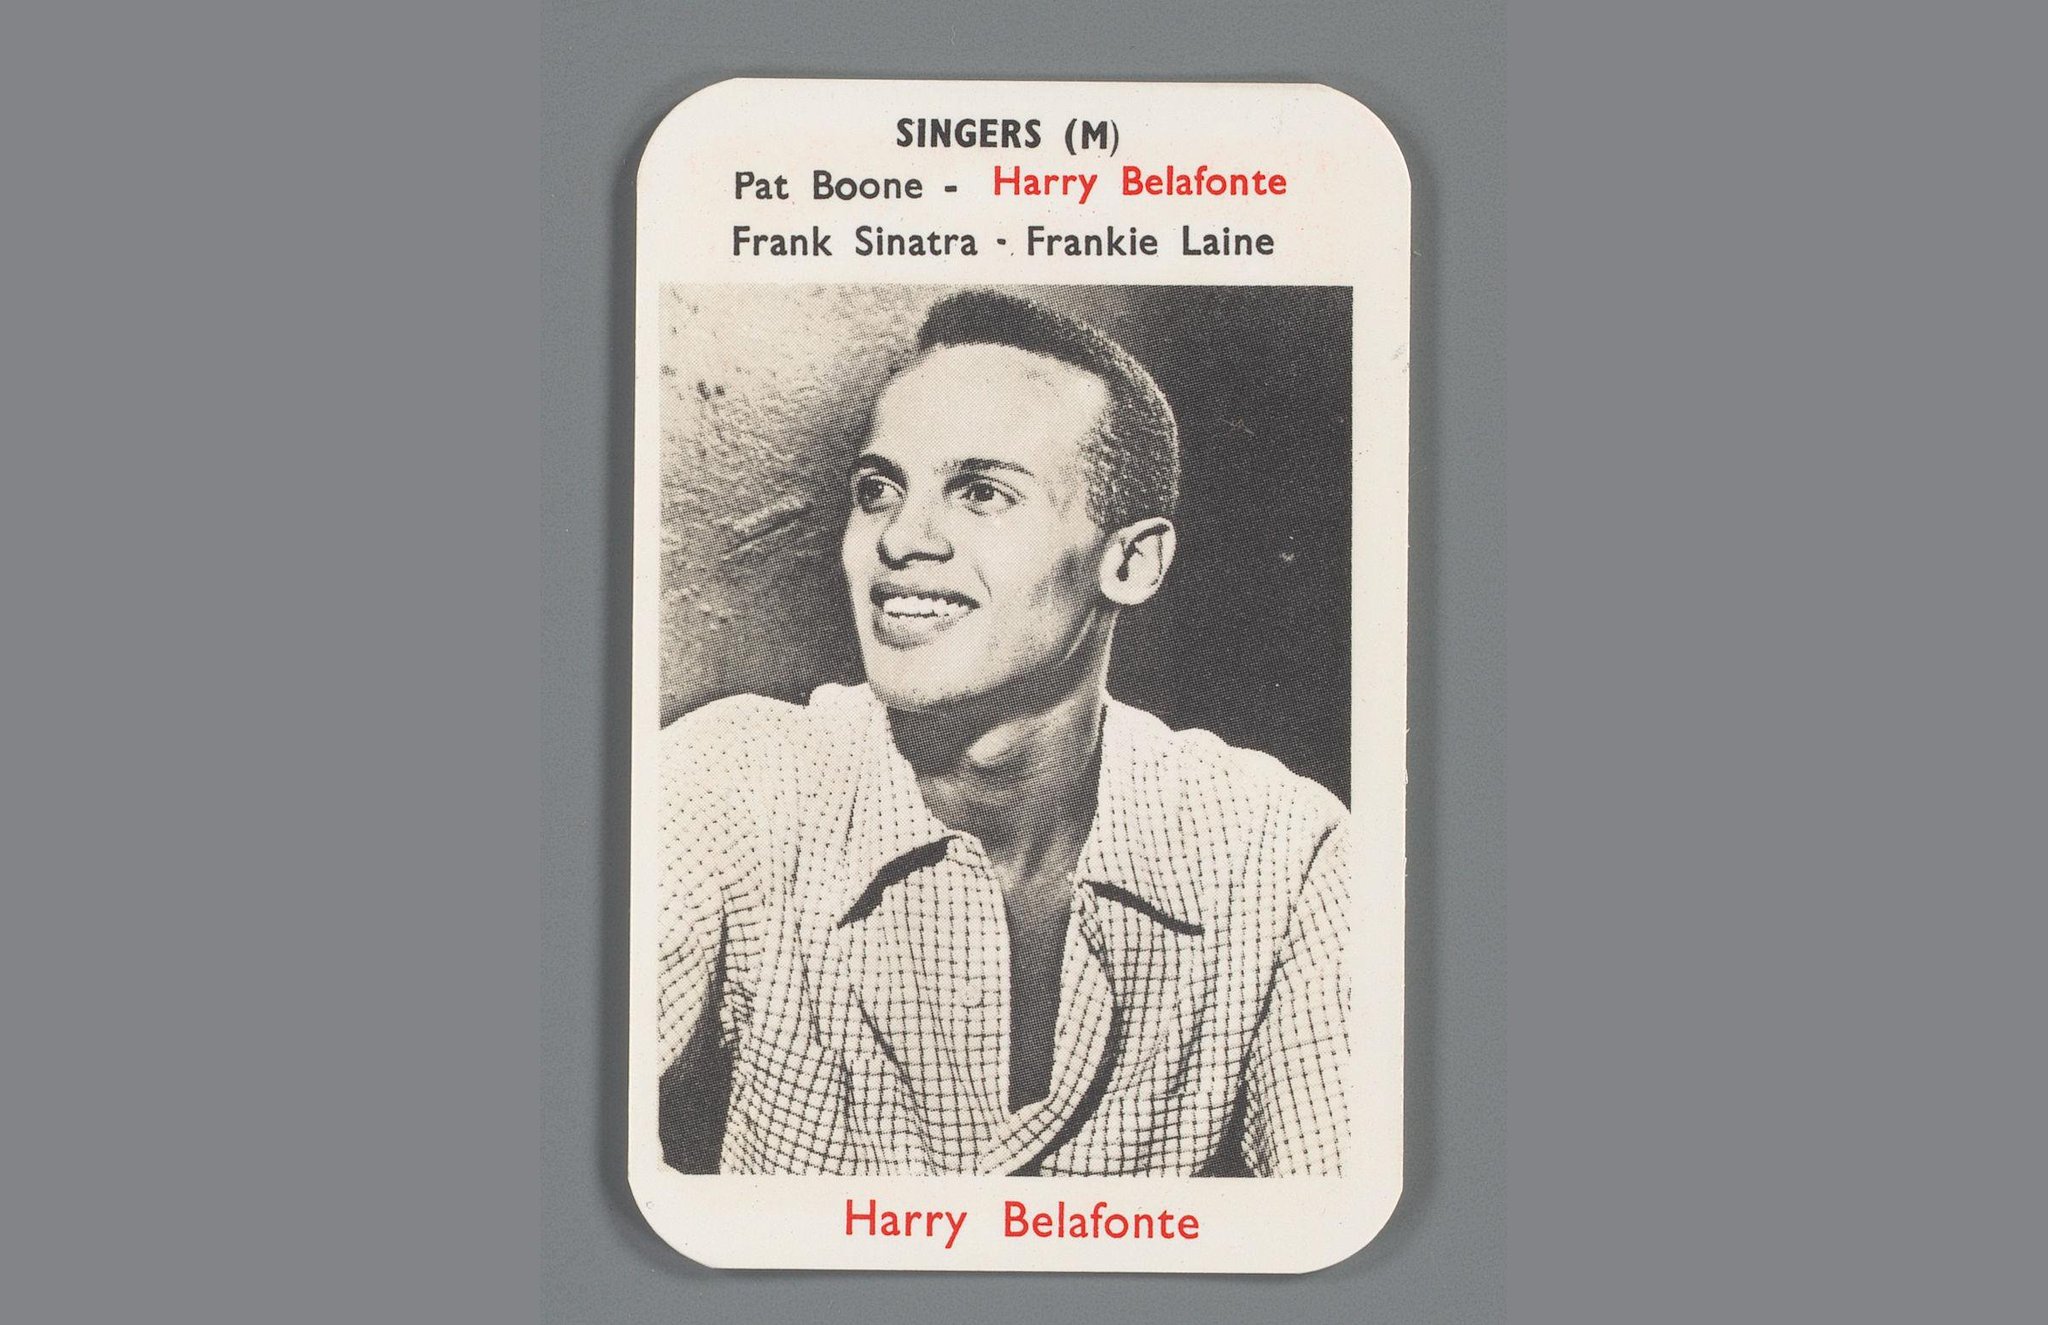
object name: playing card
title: Singers (M)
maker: Anonymous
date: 1960-1970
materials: paper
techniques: autotype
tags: new york (city), musician, portrait of a musician